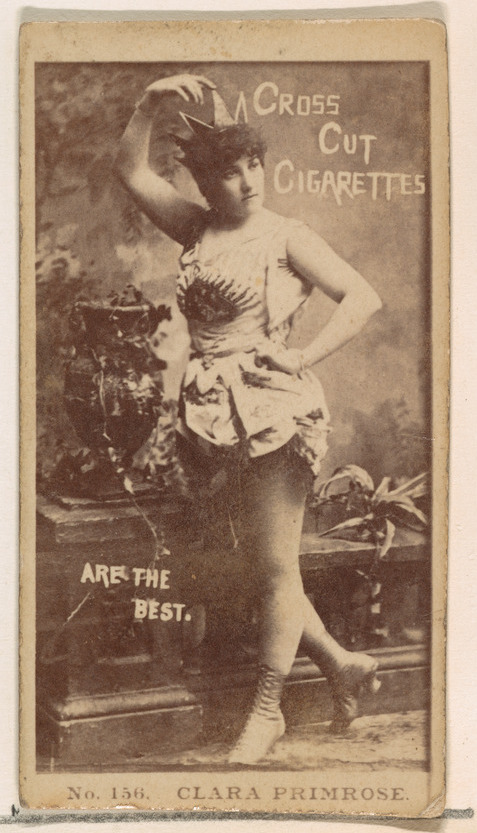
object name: print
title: Card Number 156, Clara Primrose, from the Actors and Actresses series (N145-2) issued by Duke Sons & Co. to promote Cross Cut Cigarettes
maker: w. duke, sons & co.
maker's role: publisher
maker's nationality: american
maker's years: 1870-1920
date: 1880-1889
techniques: albumen silver print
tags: portraits,women,actresses